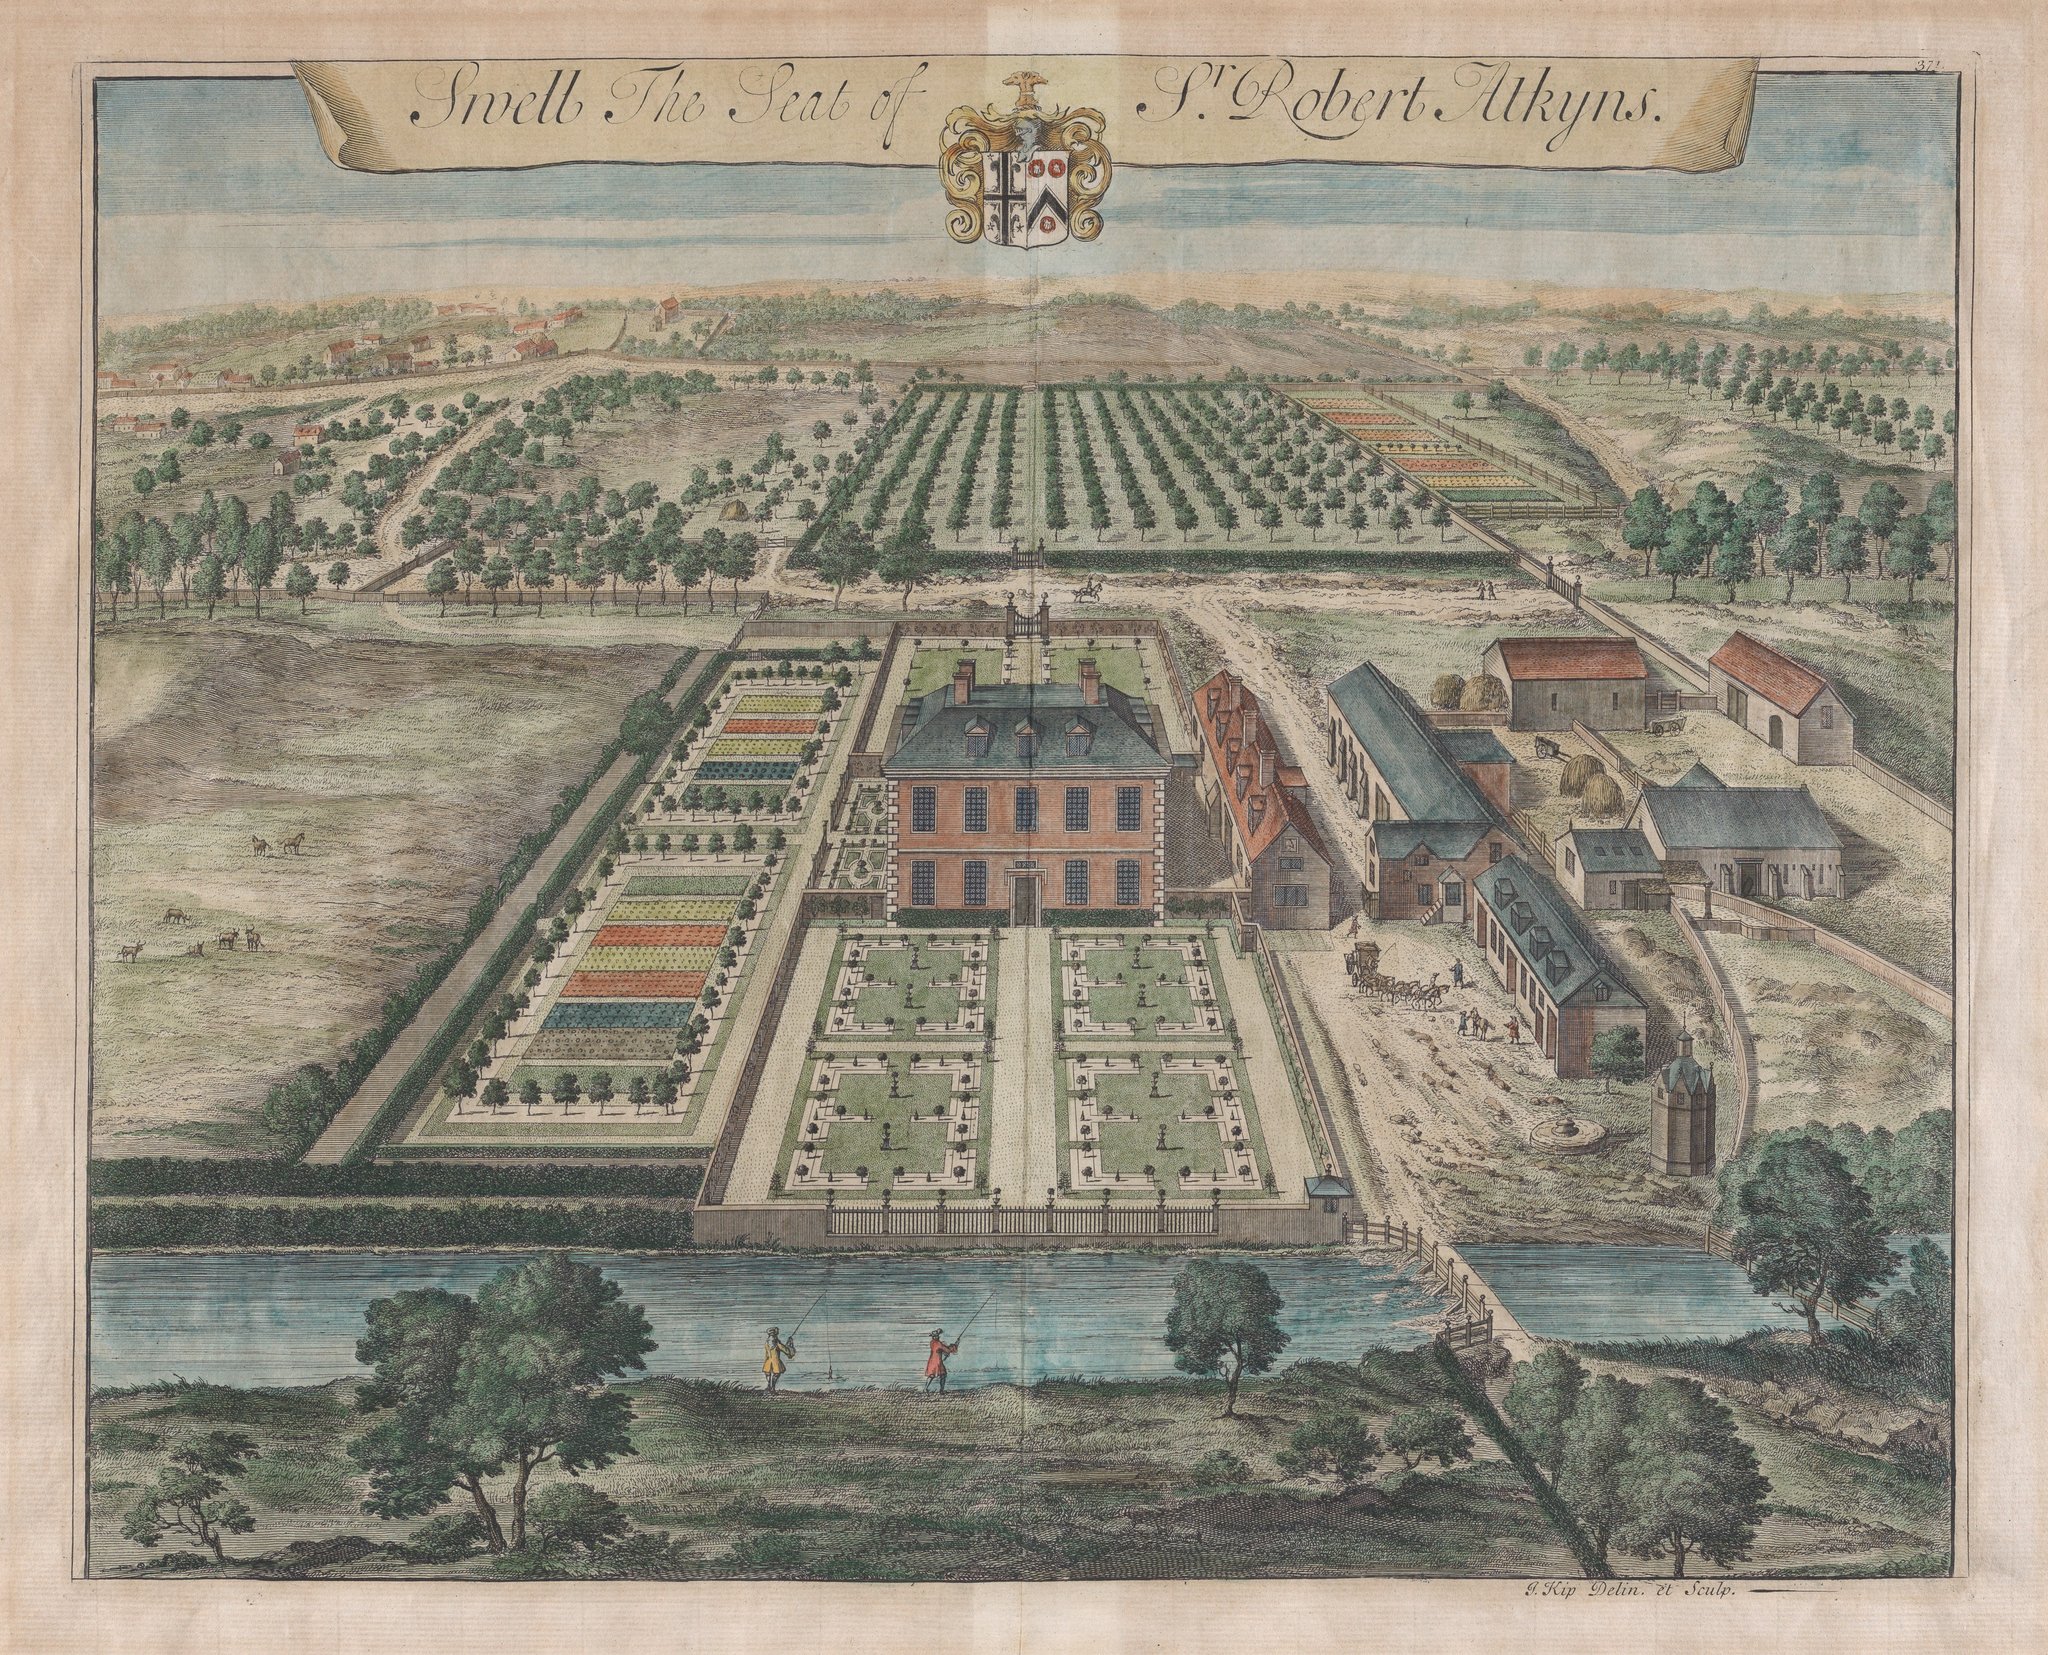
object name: print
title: Swell, The Seat of Sir Robert Atkyns, plate 371 from "The Ancient and Present State of Gloucestershire"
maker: johannes kip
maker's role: artist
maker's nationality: dutch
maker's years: 1653-1722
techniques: engraving, etching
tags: houses,gardens,landscapes,coat of arms